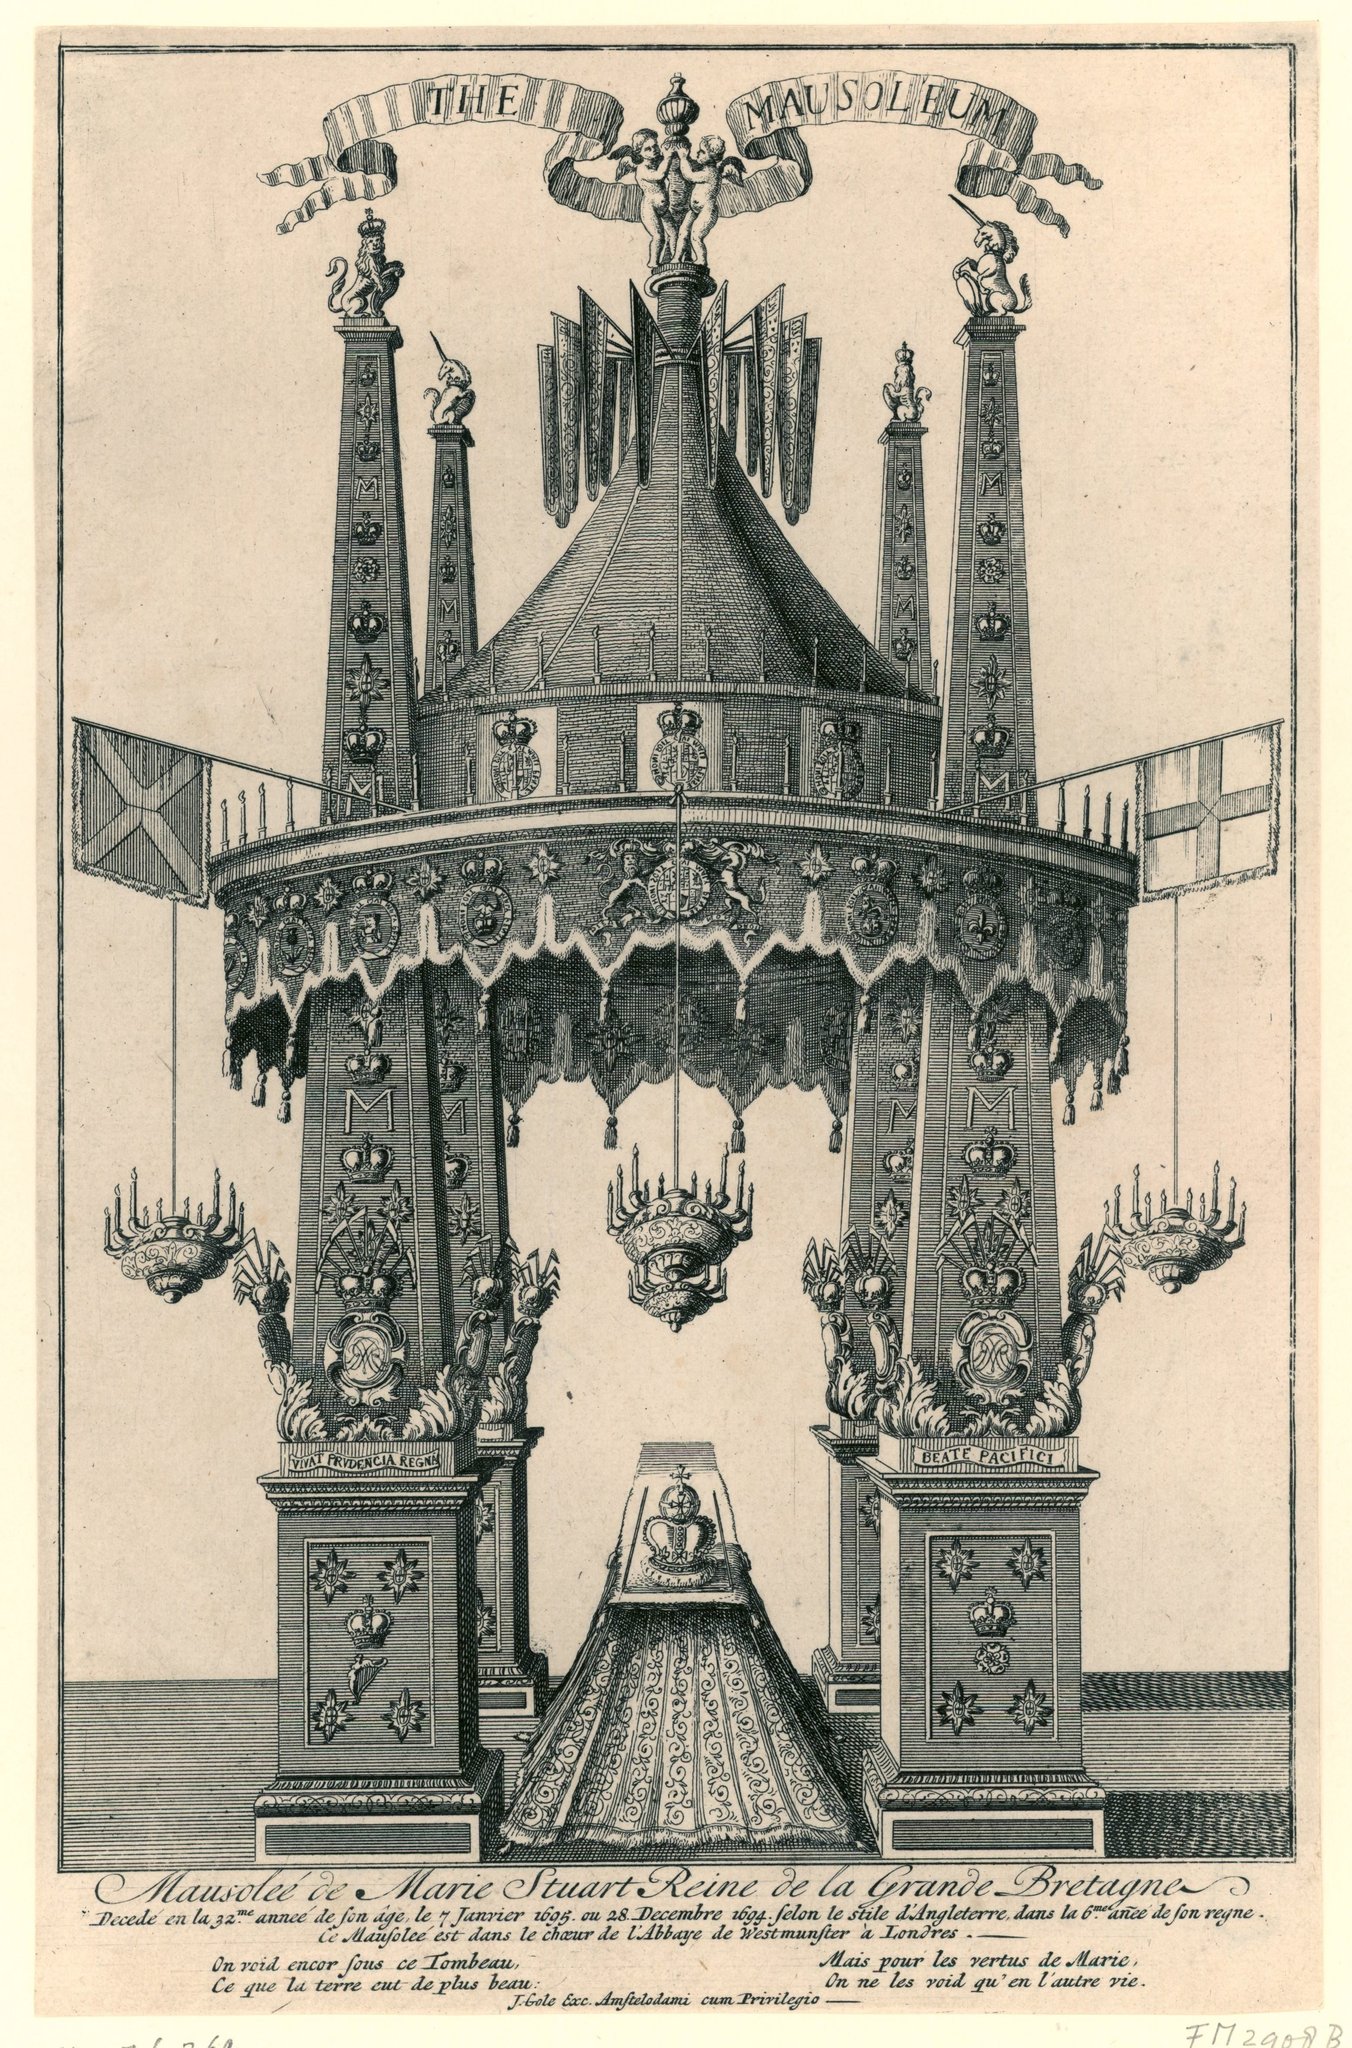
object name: print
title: Mausoleé de Marie Stuart Reine de la Grande Bretagne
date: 1695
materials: paper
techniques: etching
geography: northern netherlands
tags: london, maria ii stuart (koningin van engeland, schotland en ierland), catafalque, 'castrum doloris' (~ public funeral), westminster abbey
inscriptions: collector's mark: Lugt 963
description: Het mausoleum (katafalk) opgericht in het koor van de Westminster Abbey voor de op 7 januari 1695 overleden en op 3 maart begraven koningin Maria II Stuart. Bovenin een banderol met 'The Mausoleum'; onder de voorstelling een Frans onderschrift en vers van vier regels.